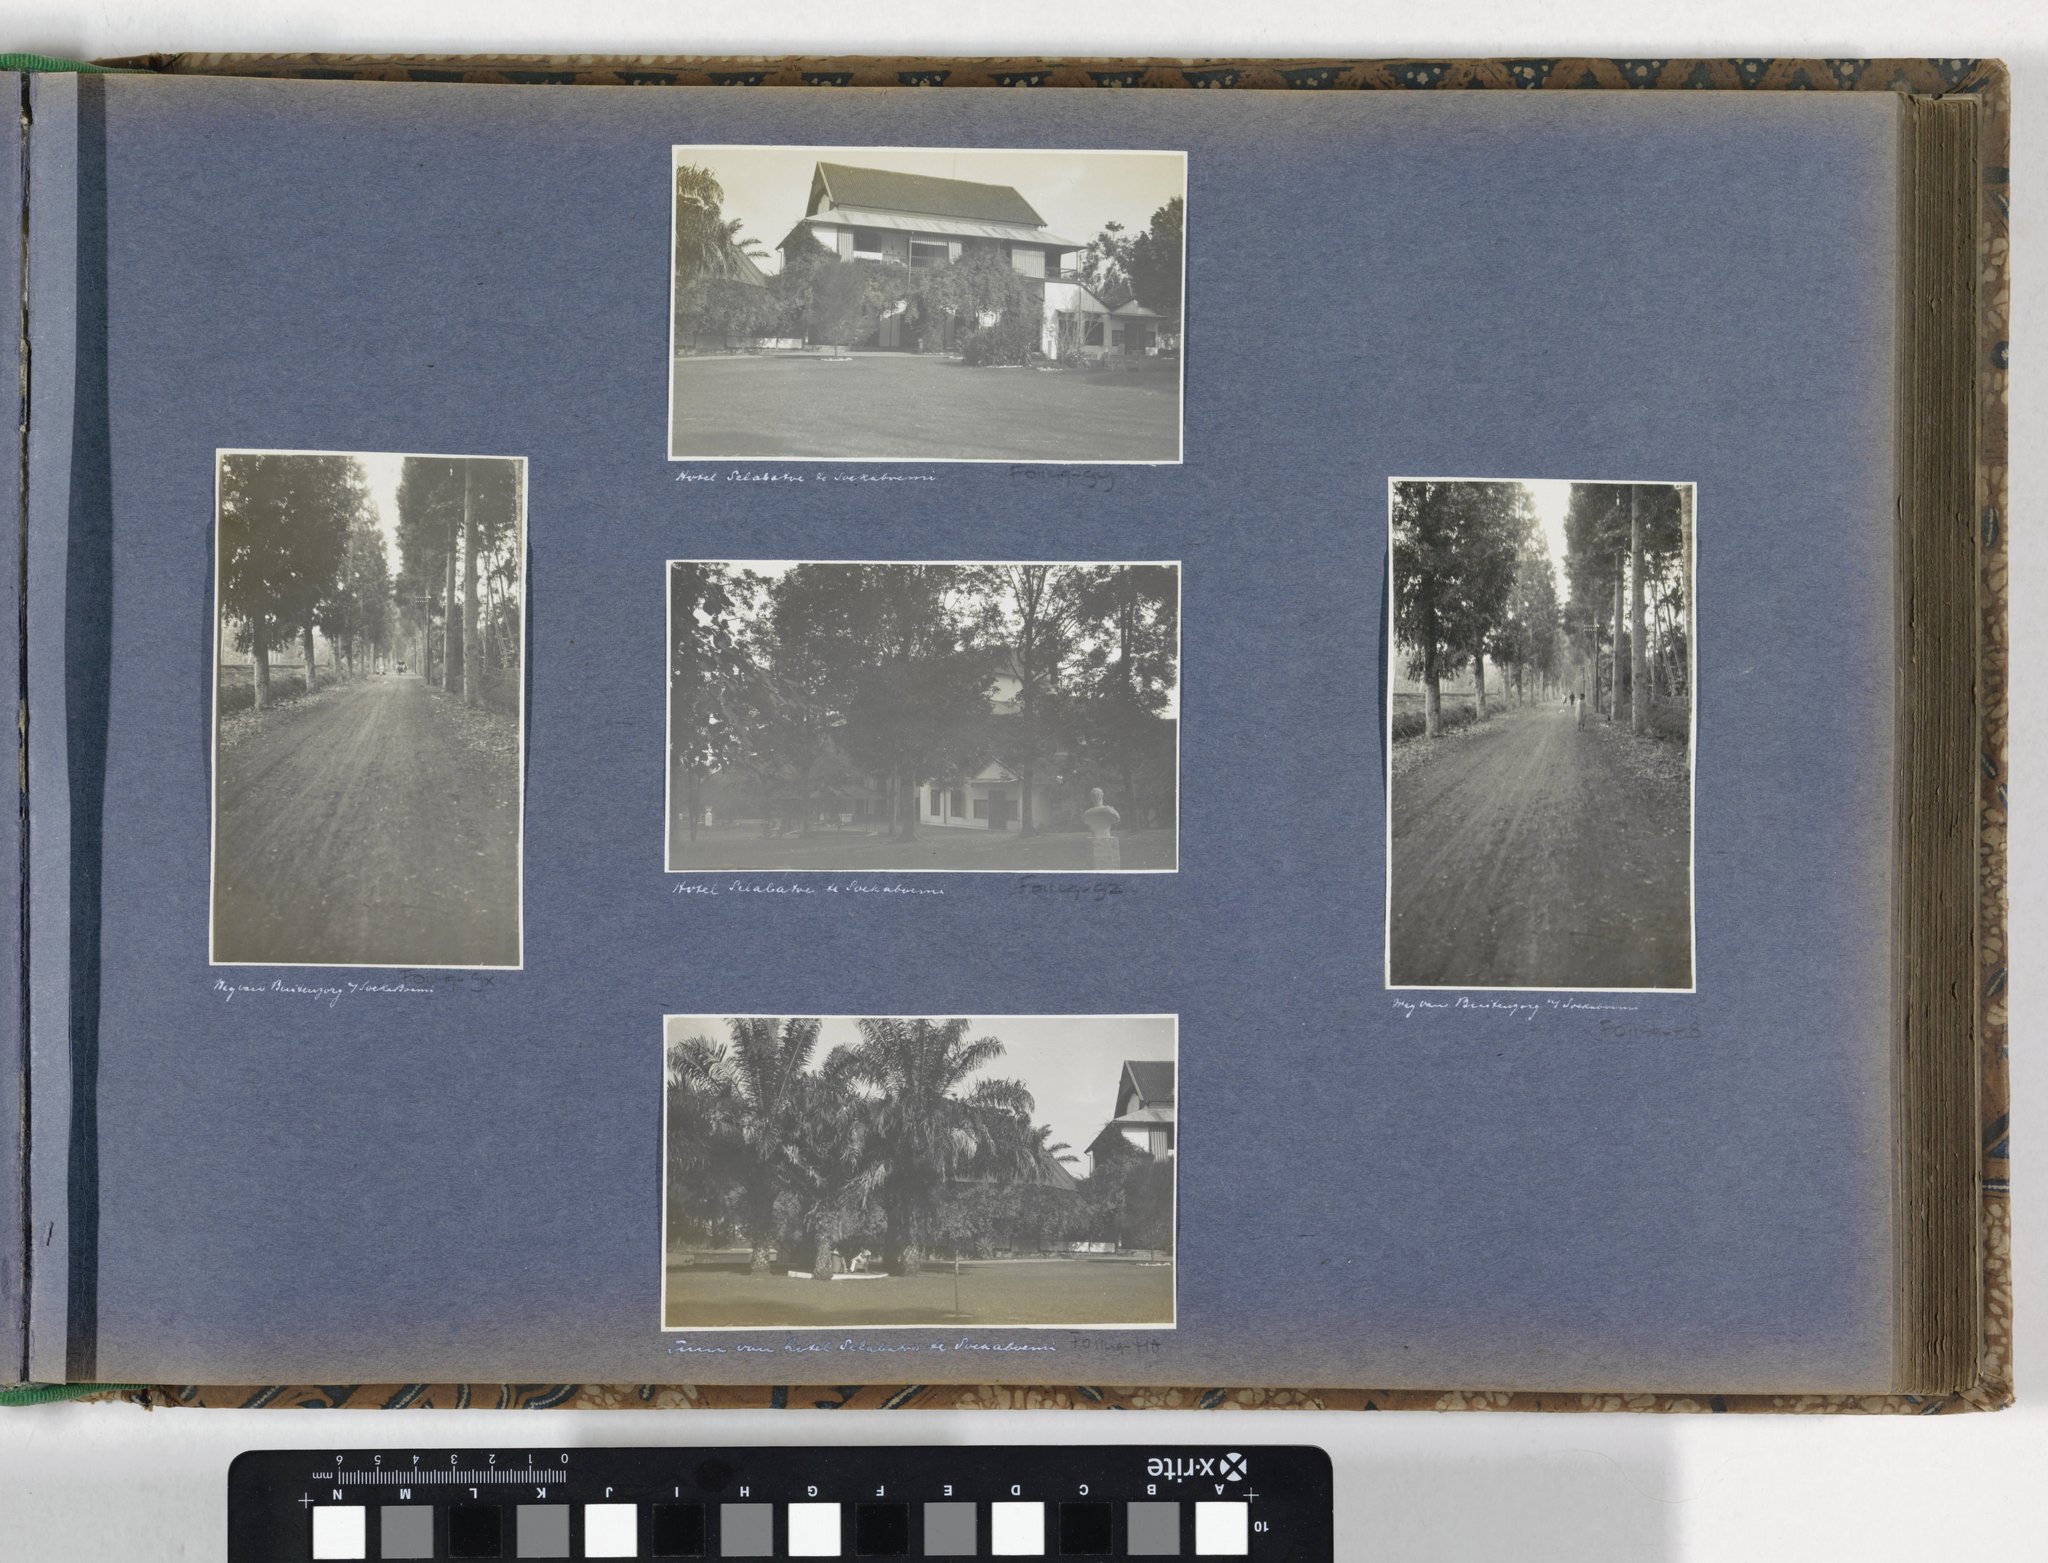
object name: photograph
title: Gasten onder palmbomen in de tuin van hotel Selabatoe te Soekaboemi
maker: Anonymous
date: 1900-1920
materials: paper, photographic support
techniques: gelatin silver print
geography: soekaboemi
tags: garden, trees: palm-tree, hotel, hostelry, inn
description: Onderdeel van reisalbum met foto's van bedrijvigheid en bezienswaardigheden op Sumatra en Java en van de reis naar en van Nederlands-Indië.